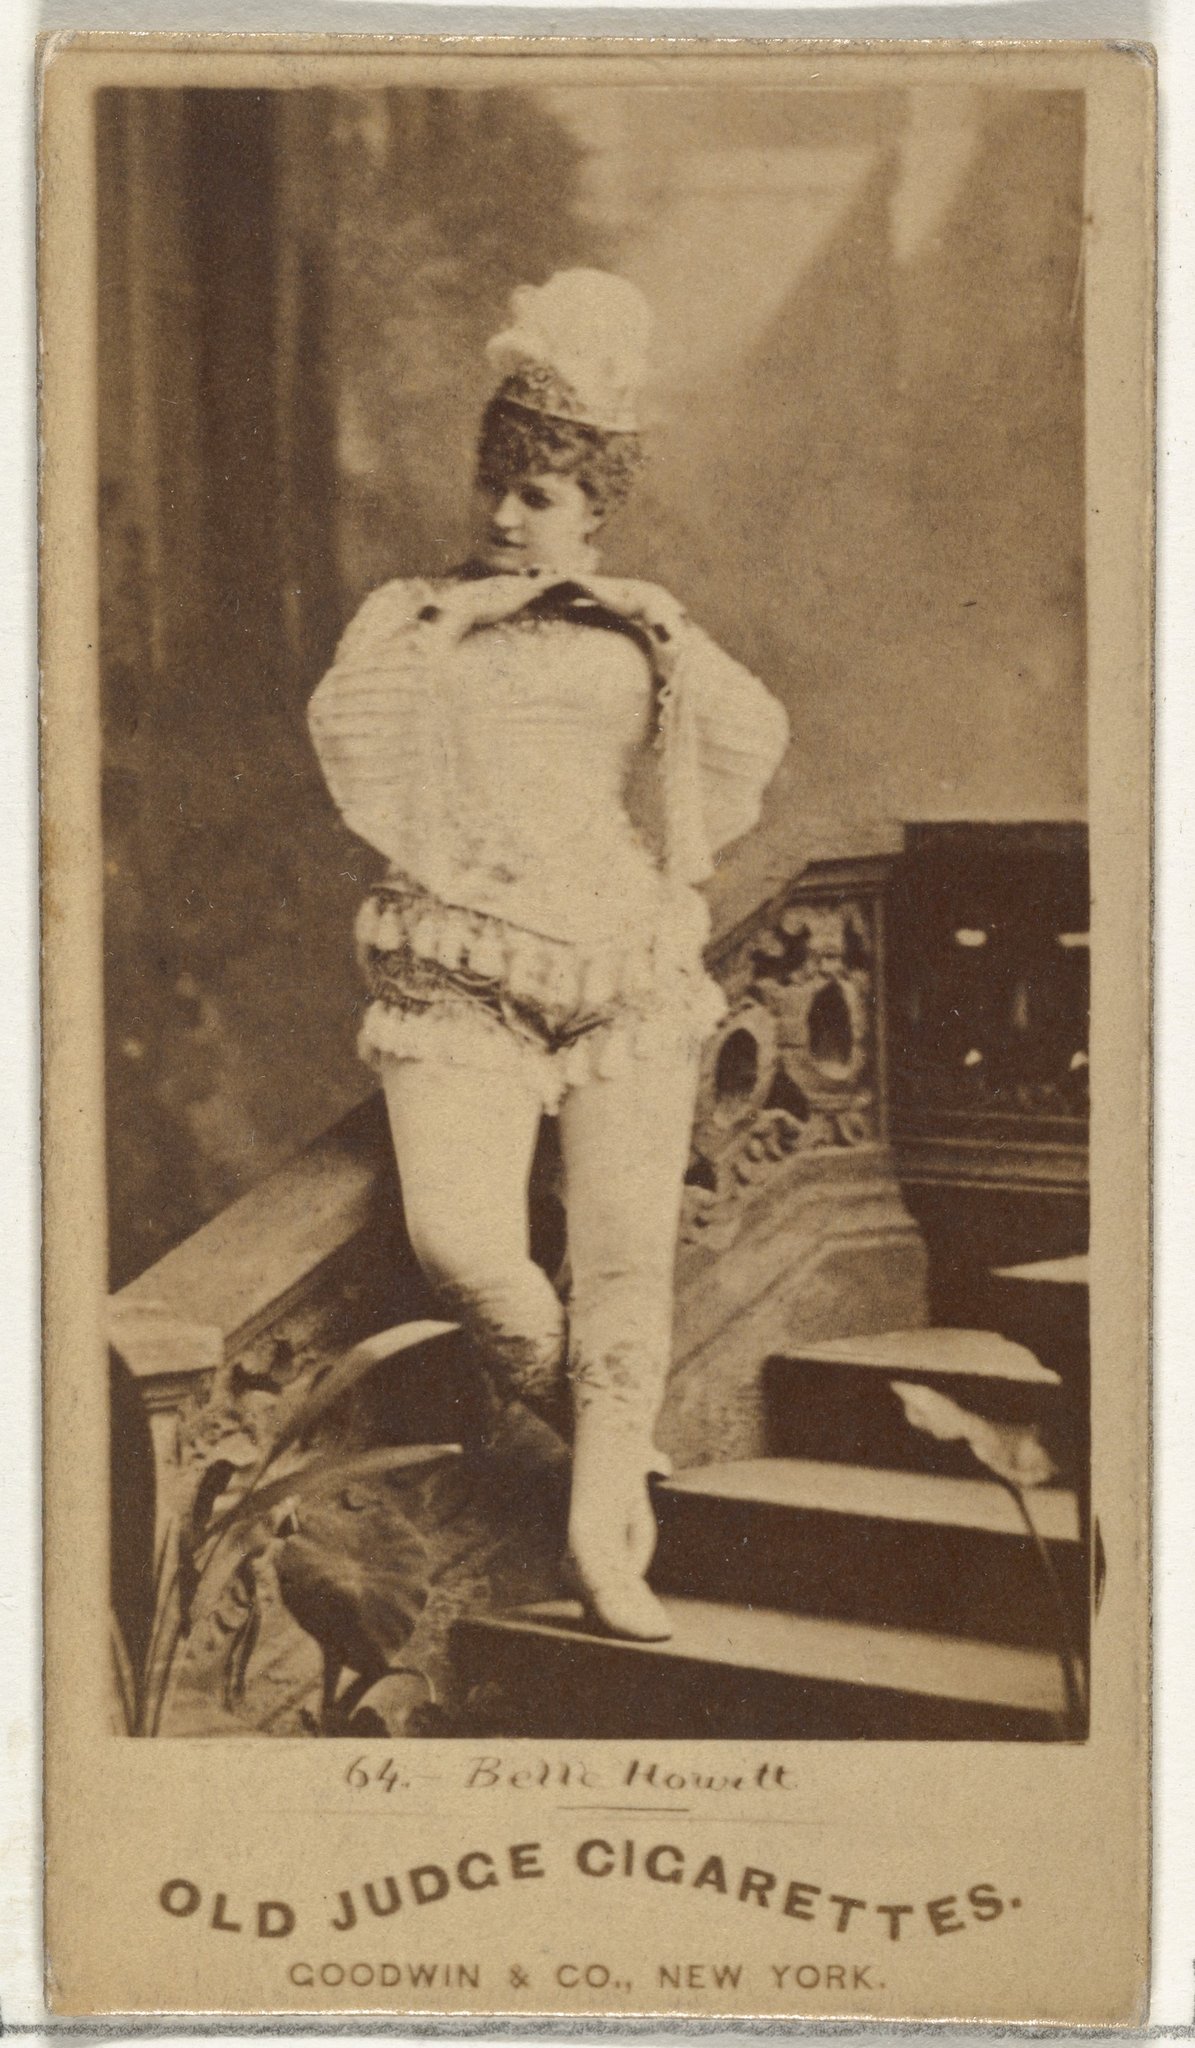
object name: photograph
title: Bette Howett, from the Actors and Actresses series (N171) for Old Judge Cigarettes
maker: goodwin & company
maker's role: publisher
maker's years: 1850-1950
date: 1886-1890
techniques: albumen silver print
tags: portraits,women,actresses